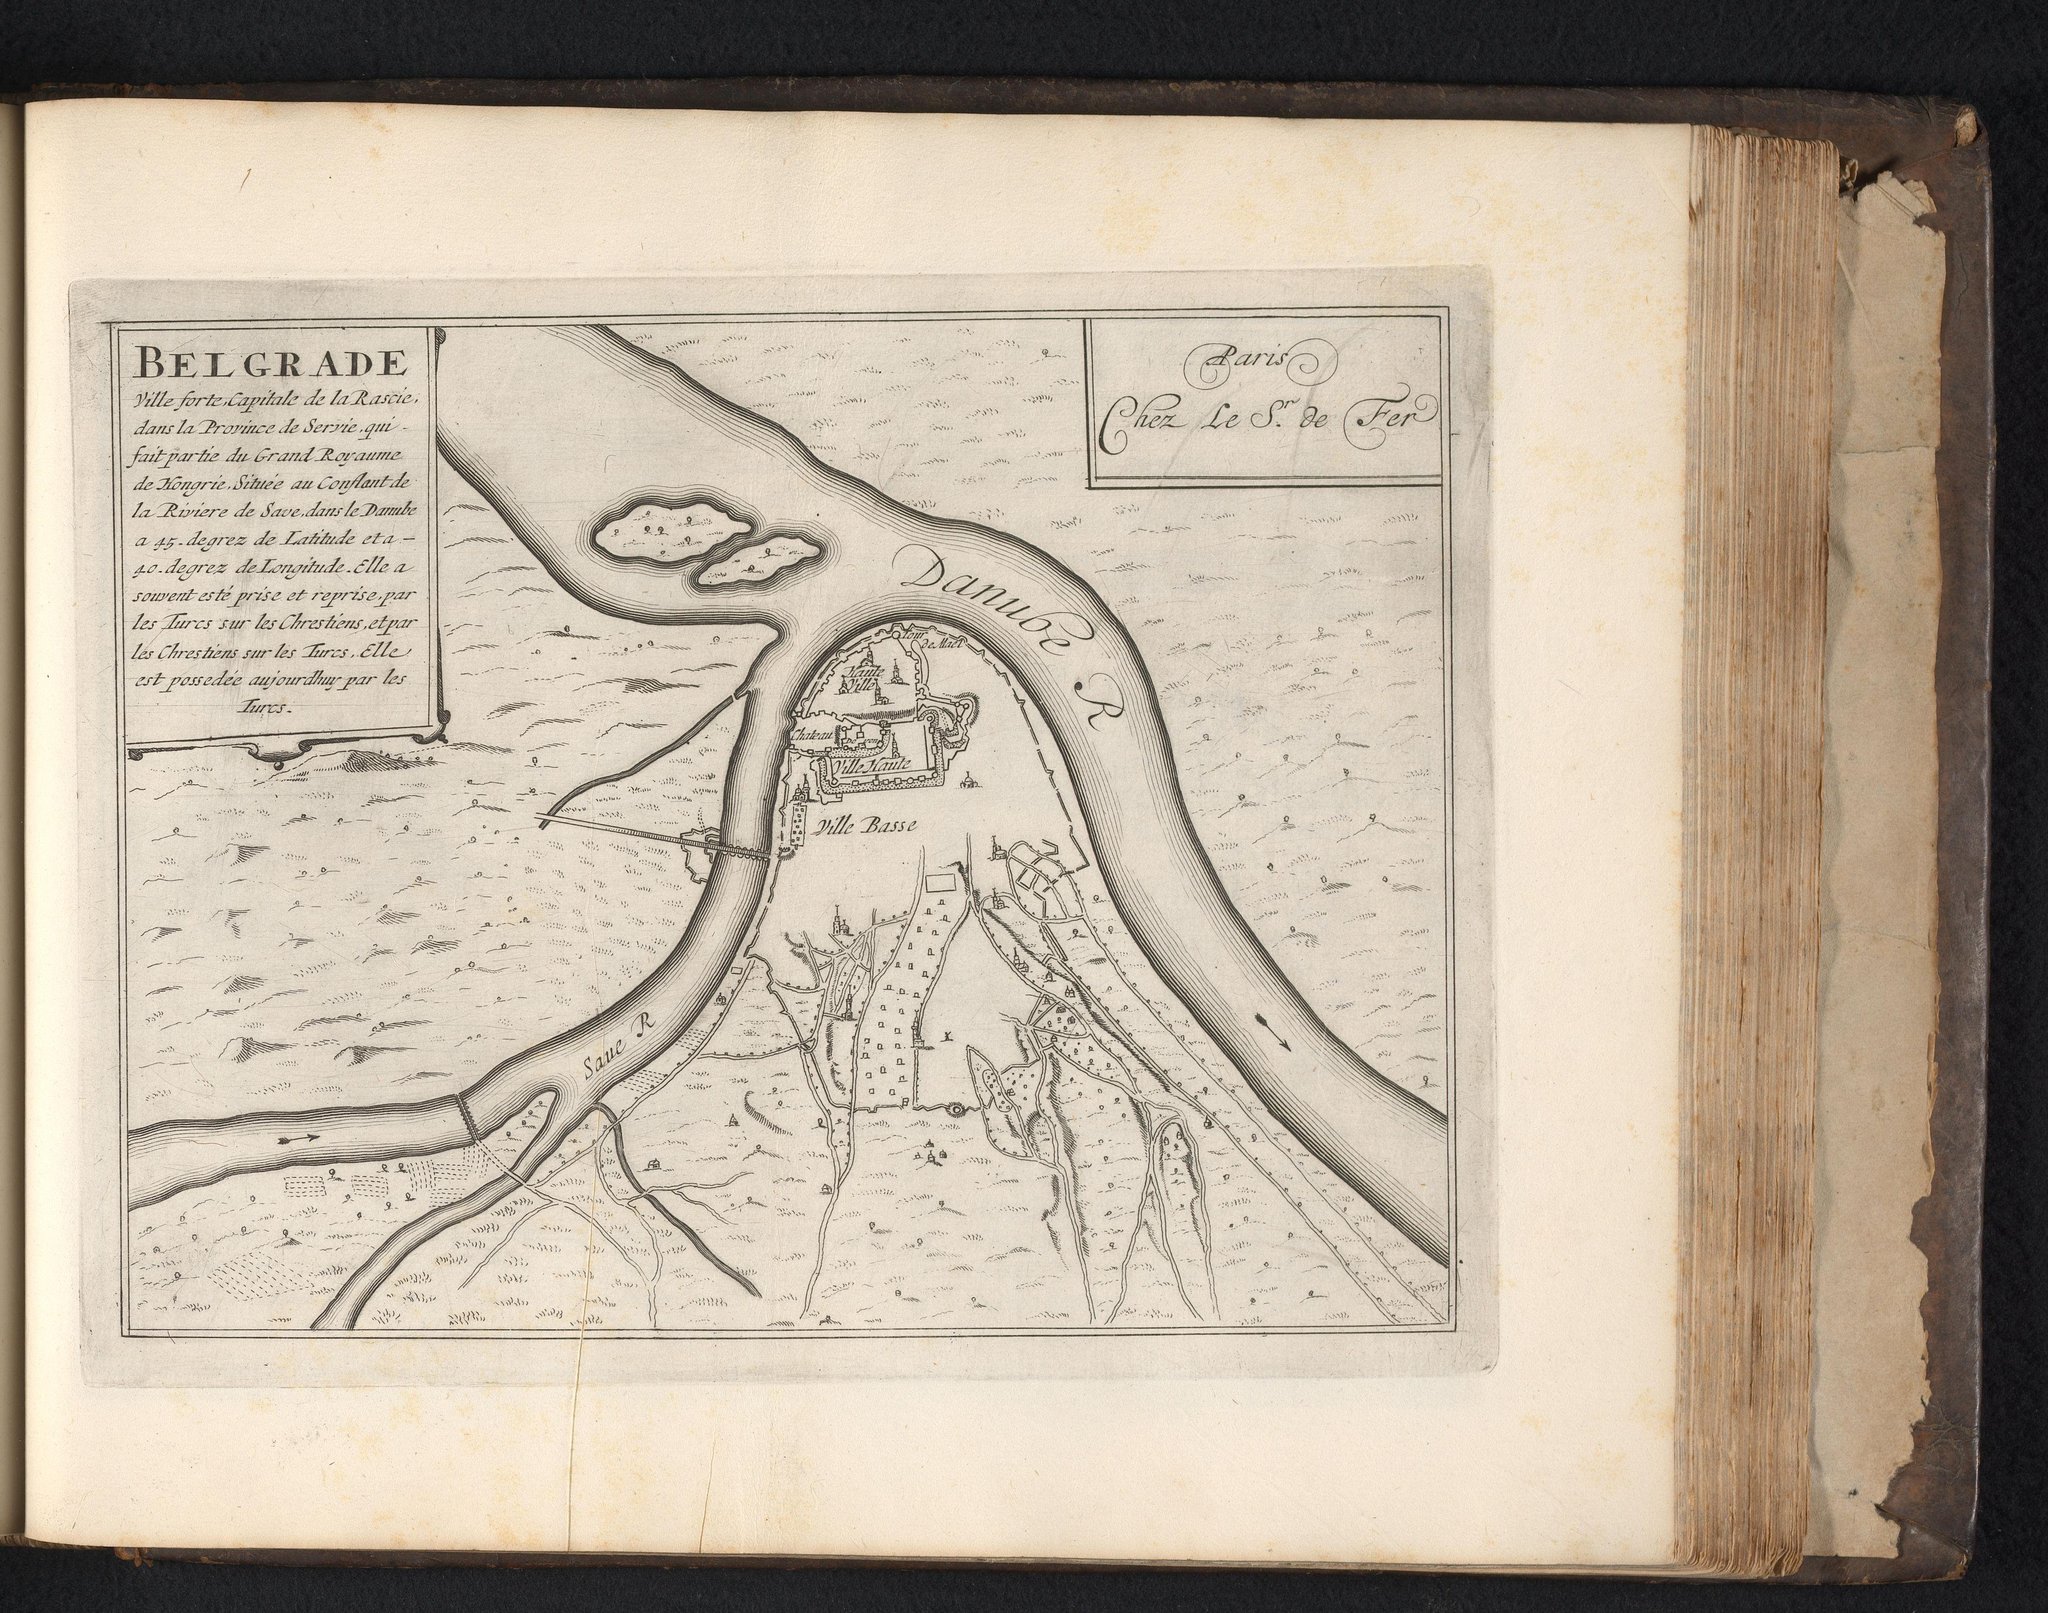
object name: map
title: Kaart van Belgrado, ca. 1695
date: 1695-1697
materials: paper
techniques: etching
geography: france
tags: fortress, maps of cities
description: Kaart van Belgrado aan de Donau en omgeving. Onderdeel van het achtste deel (1697) van het prentwerk waarin gebundeld zijn de acht delen van Les forces de l'Europe uitgegeven tussen 1693-1697. Het prentwerk bestaat uit 175 platen met plannen (afkomstig van Sébastien Le Prestre, Seigneur de Vauban) van vermaarde sterke steden en vestingen in de Negenjarige Oorlog. Titel en opschriften in het Frans.